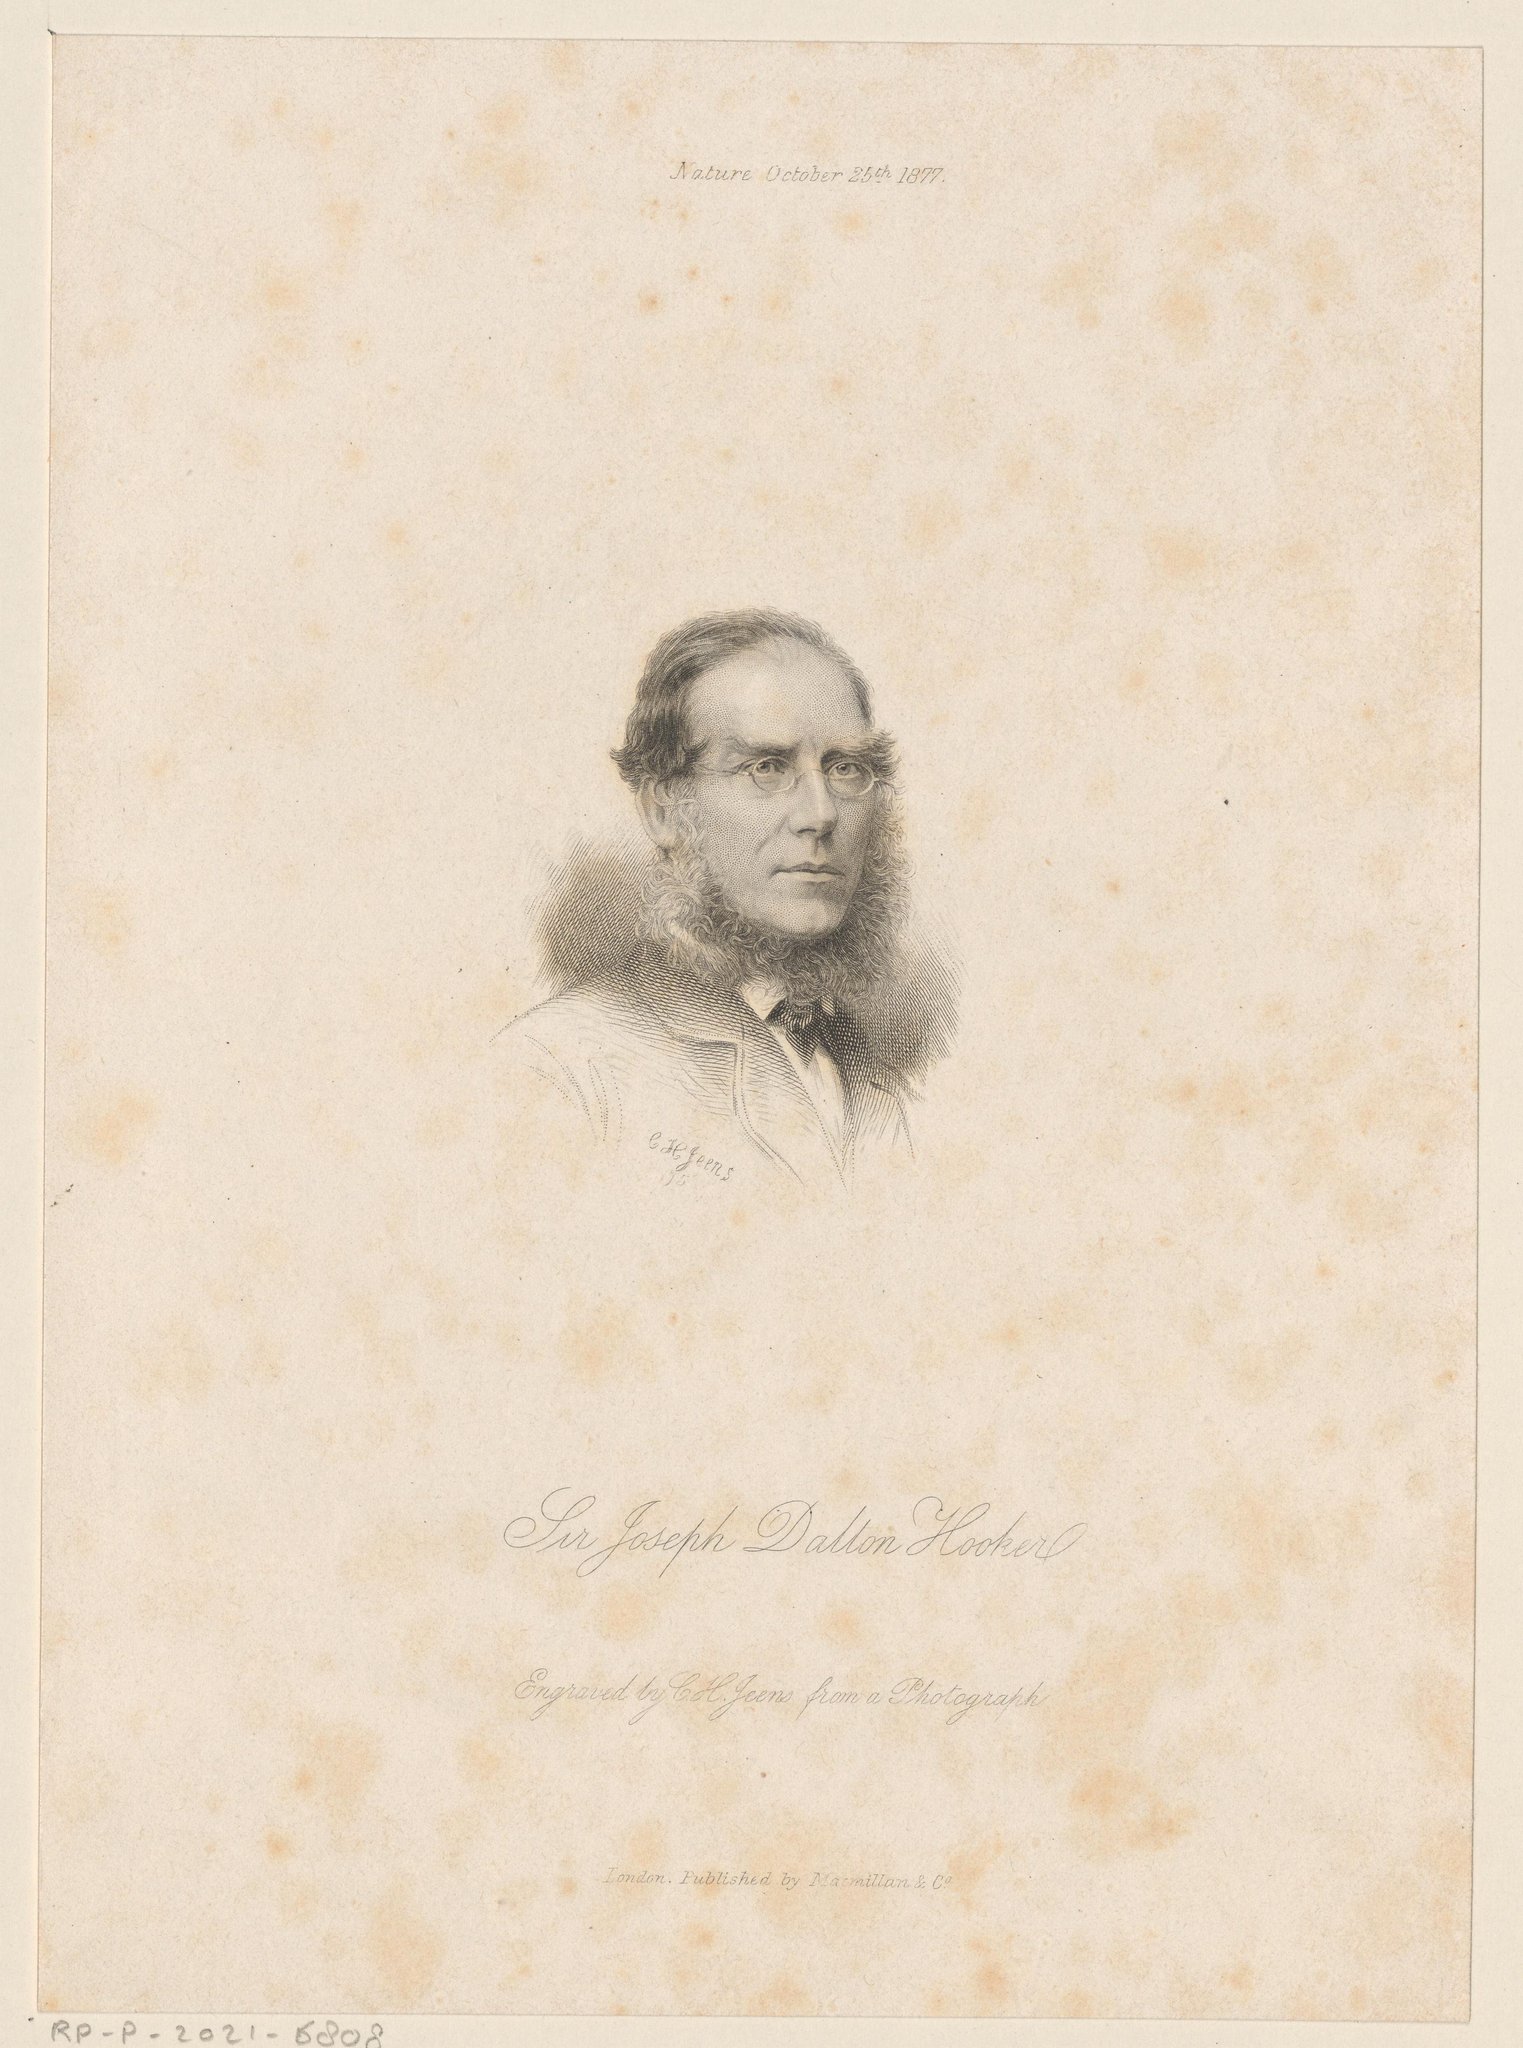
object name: print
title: Portret van Joseph Dalton Hooker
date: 1877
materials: paper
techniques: engraving, etching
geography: london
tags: eyeglasses, spectacles, botany (+ portrait of scholar, scientist), historical persons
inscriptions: date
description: Prent uit: Nature 16 (1877), 25 oktober 1877.